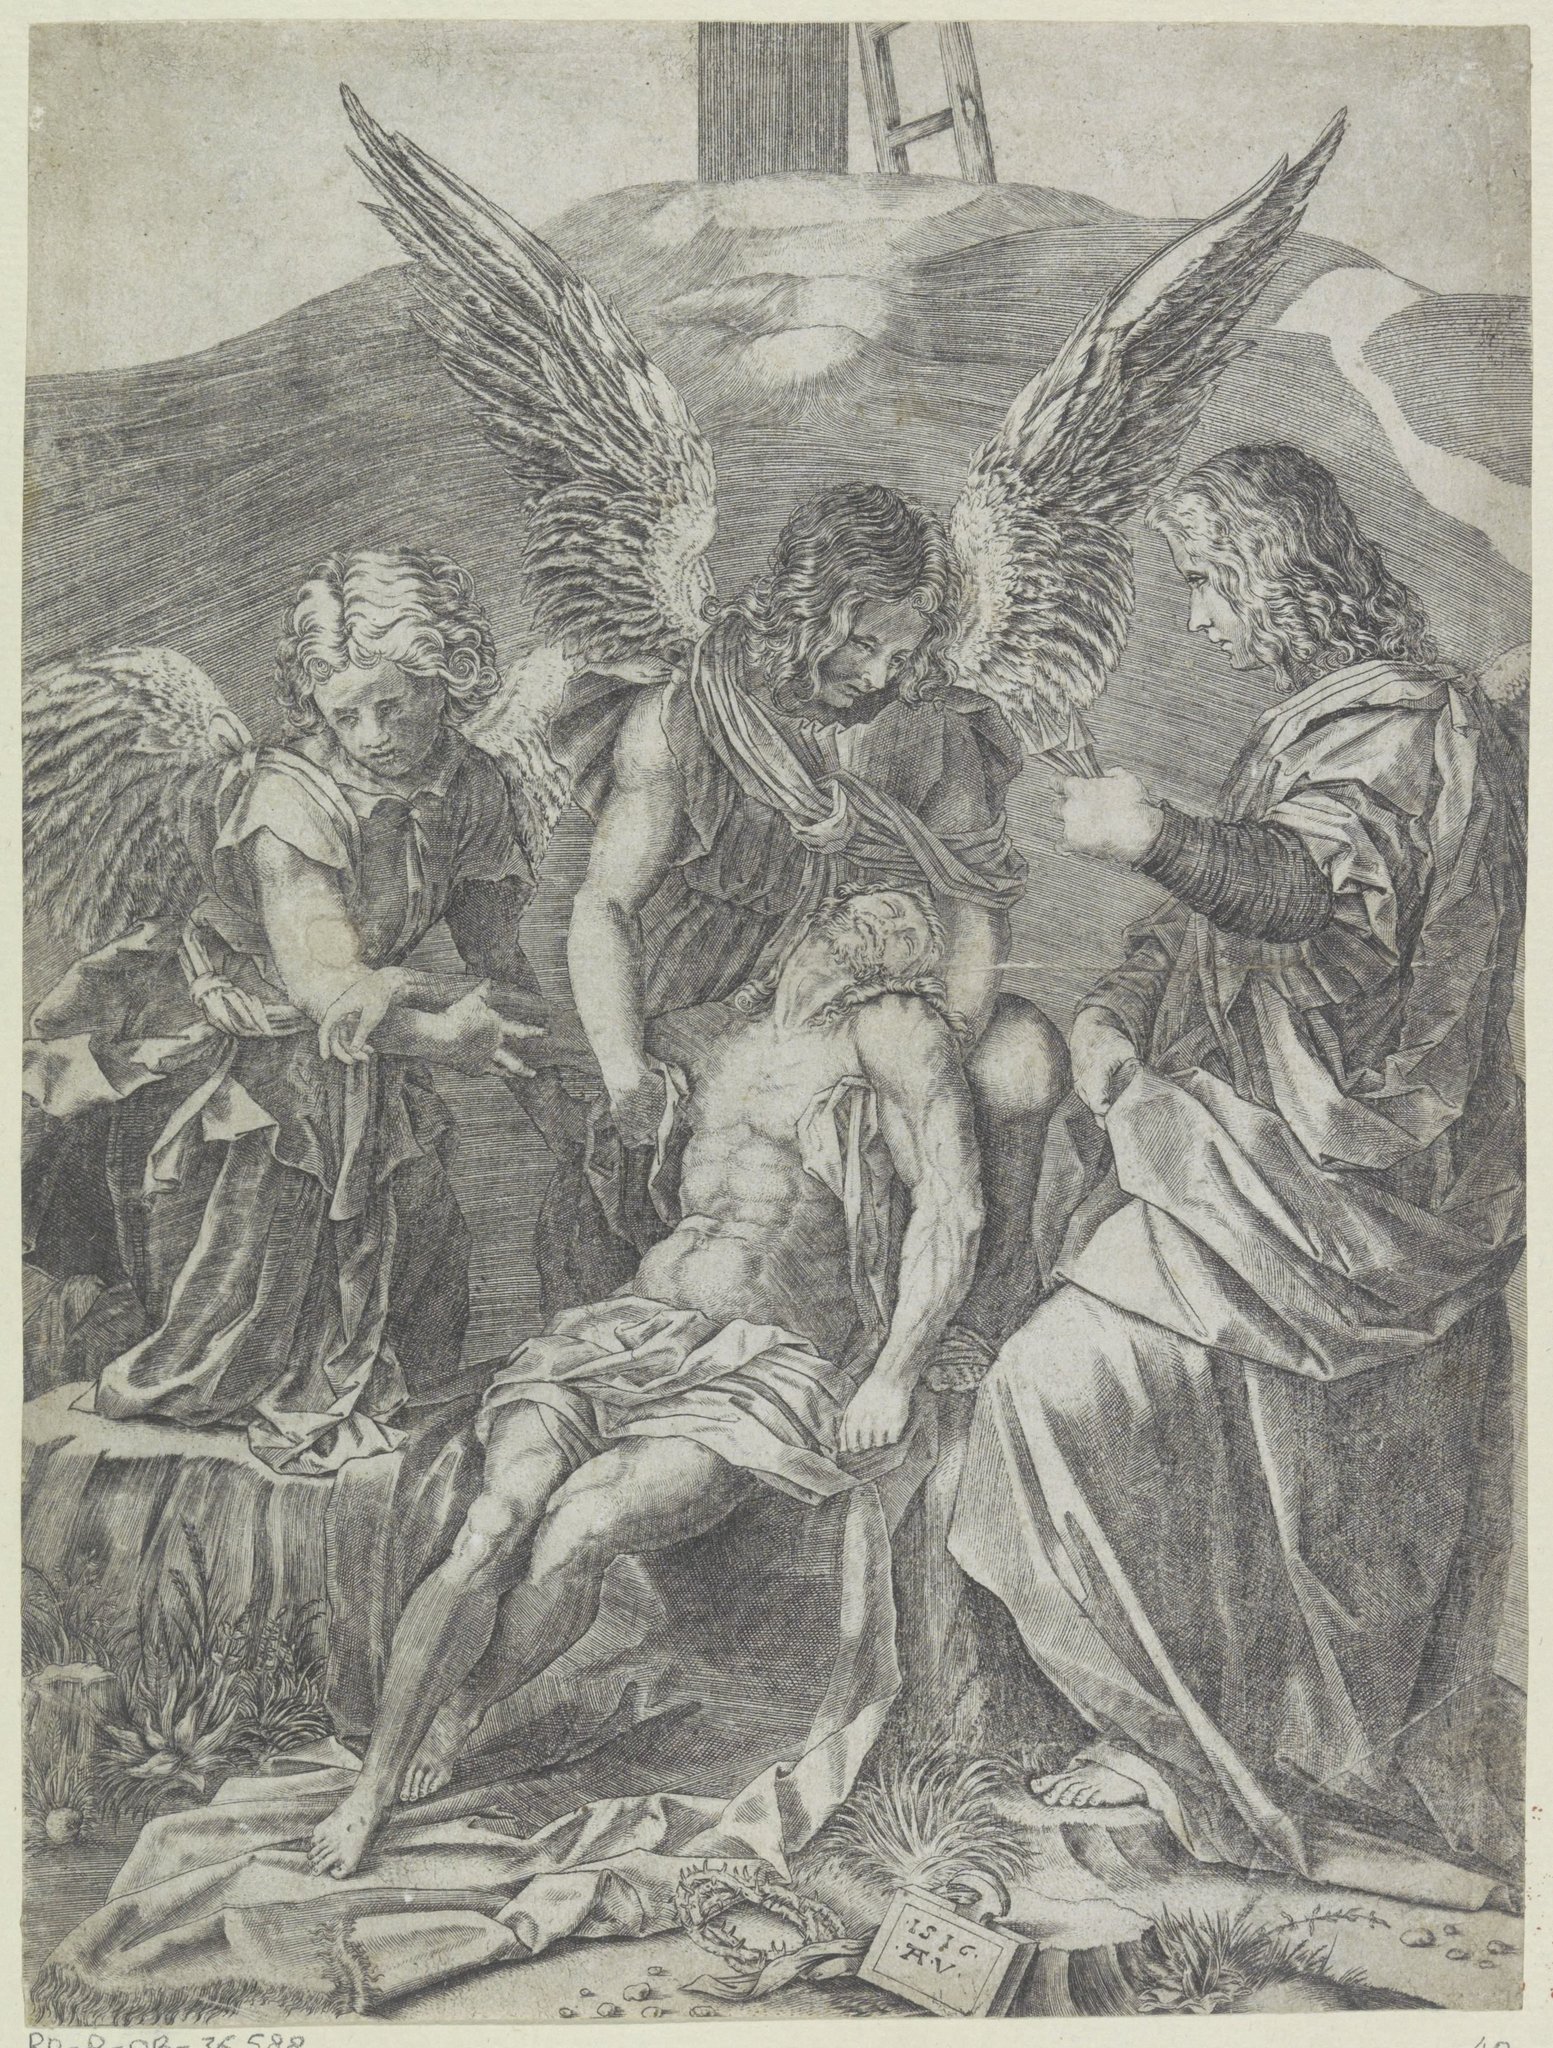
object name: print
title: Bewening van Christus door drie engelen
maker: agostino veneziano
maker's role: draughtsman, painter, print maker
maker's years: 1490-1536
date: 1516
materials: paper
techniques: engraving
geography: italy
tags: christ lamented by angels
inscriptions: date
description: Een engel ondersteunt Christus' lichaam, twee andere engelen staan naast hen. Op de achtergrond de onderkant van het kruis. Op de voorgrond de doornenkroon.